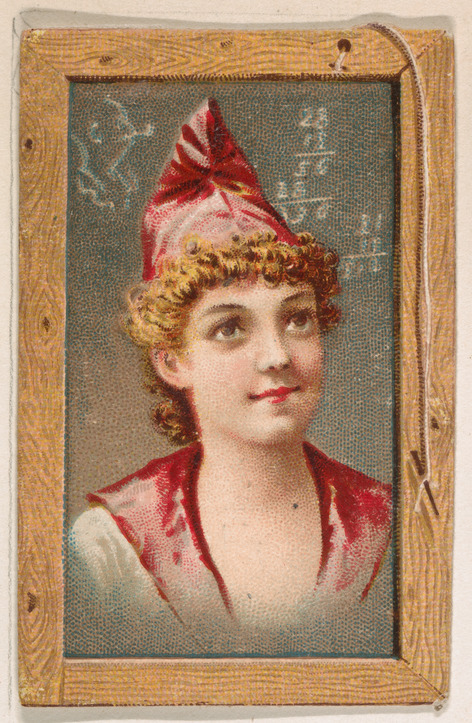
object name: print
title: Chalkboard, from the Novelties series (N228, Type 3) issued by Kinney Bros.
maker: kinney brothers tobacco company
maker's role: publisher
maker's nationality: american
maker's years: 1869-2011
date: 1889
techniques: color lithograph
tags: women